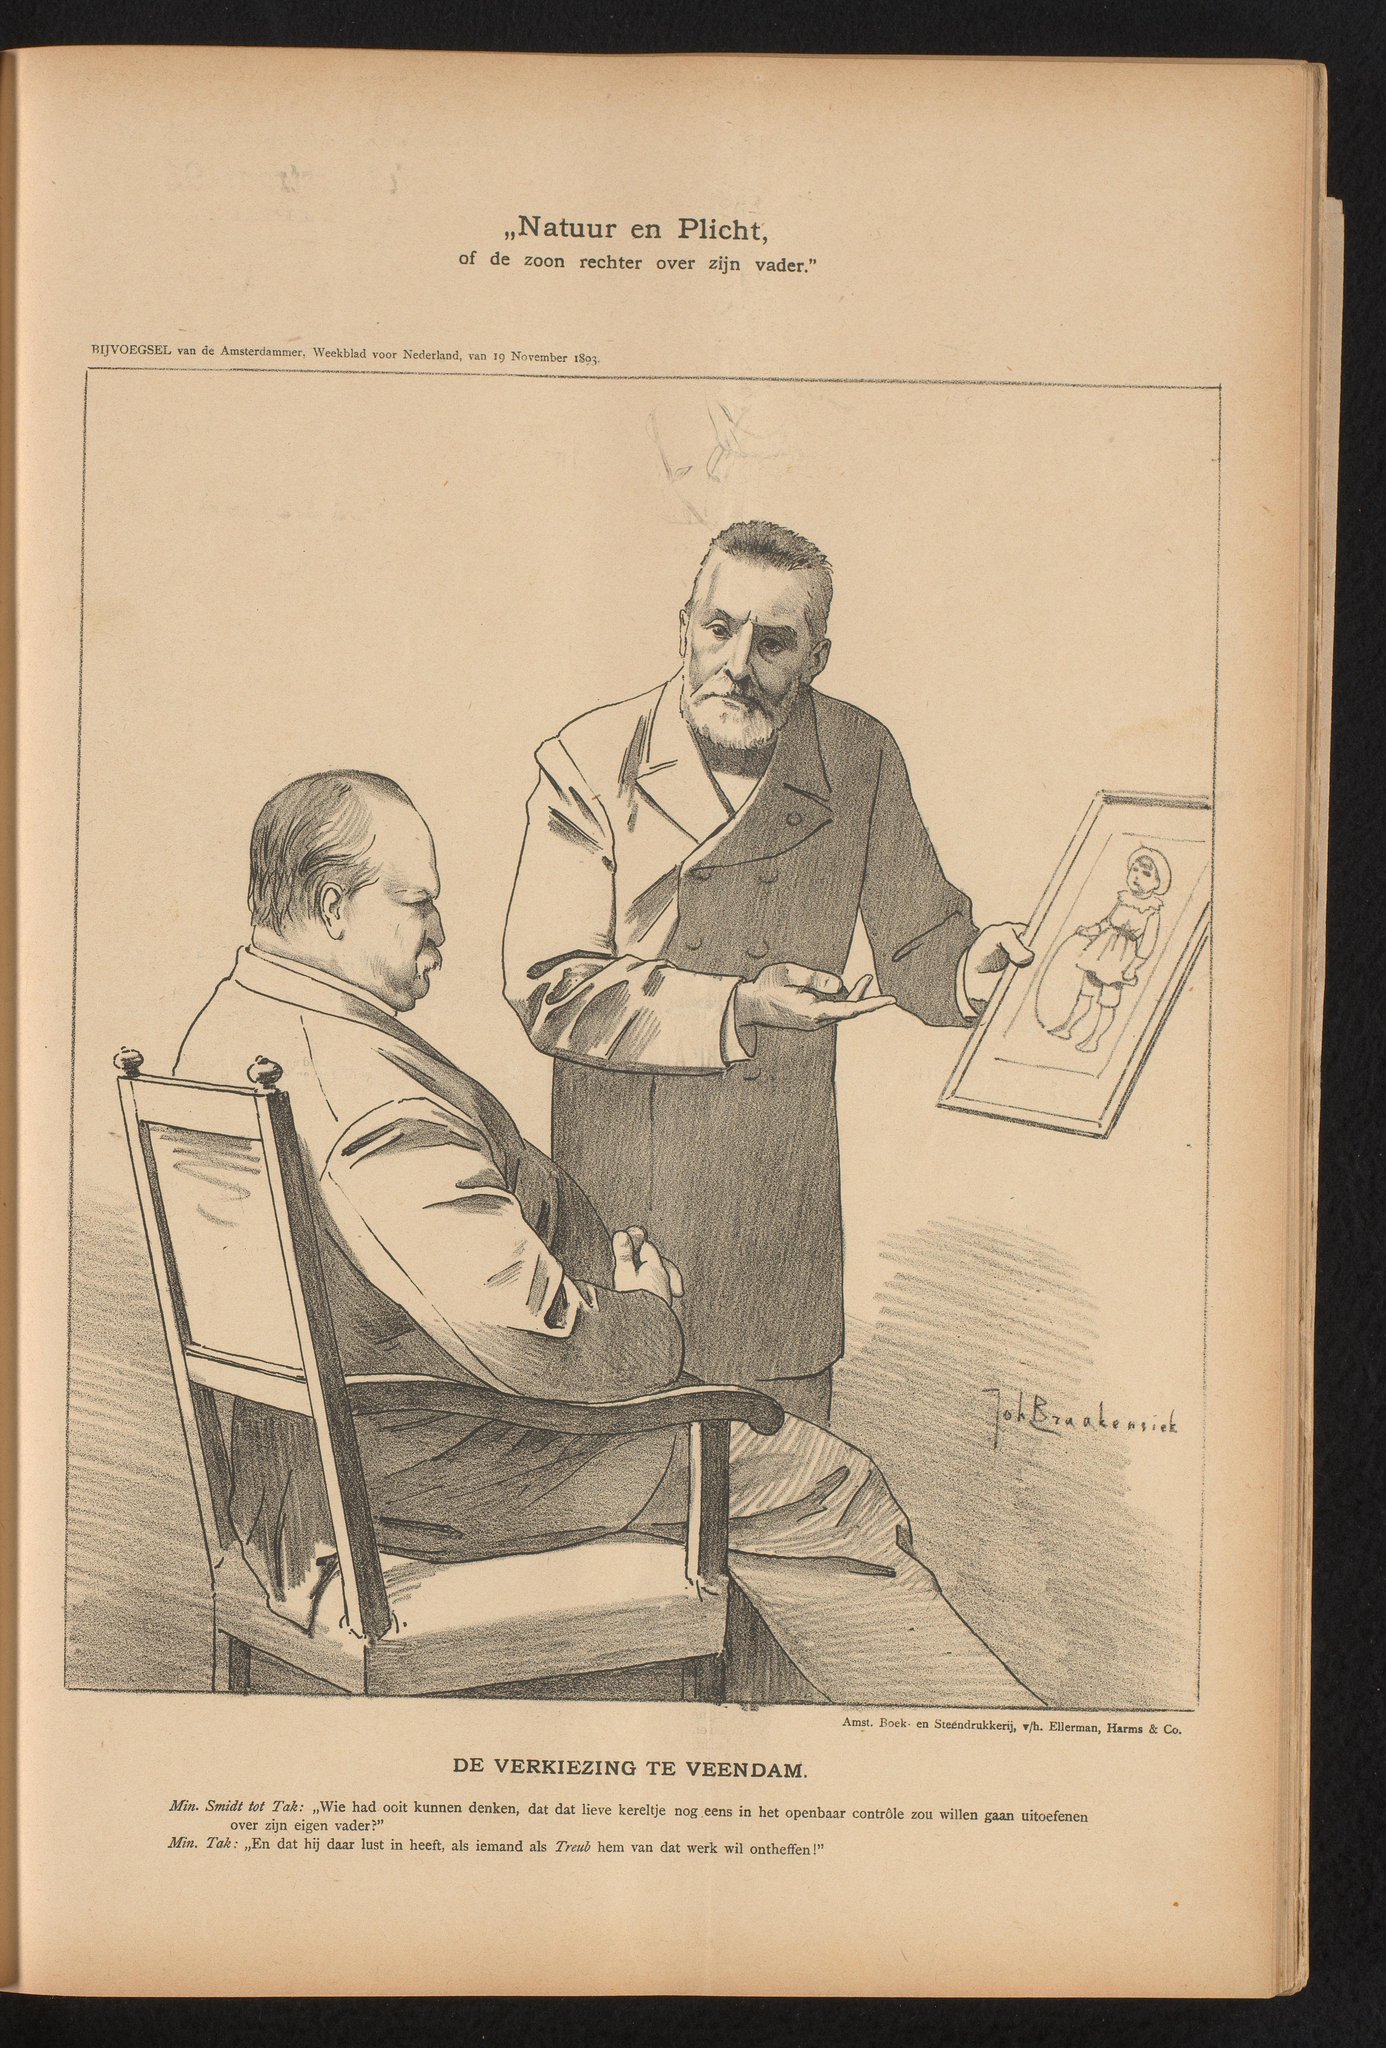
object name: cartoon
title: "Natuur en Plicht, of de zoon rechter over zijn vader."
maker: johan braakensiek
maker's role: draughtsman, print maker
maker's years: 1858-1940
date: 1893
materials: paper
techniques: lithograph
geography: amsterdam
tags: the hague, minister ~ government, voting, election, political caricatures and satires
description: Minister van Justitie Hendrik Jan Smidt toont minister van Binnenlandse Zaken Johannes Tak van Poortvliet een tekening van een kind. Naar aanleiding van de tussentijdse verkiezingen in het district Veendam waar Eerke Albert Smidt, de zoon van de minister, met één stem Willem Treub versloeg.